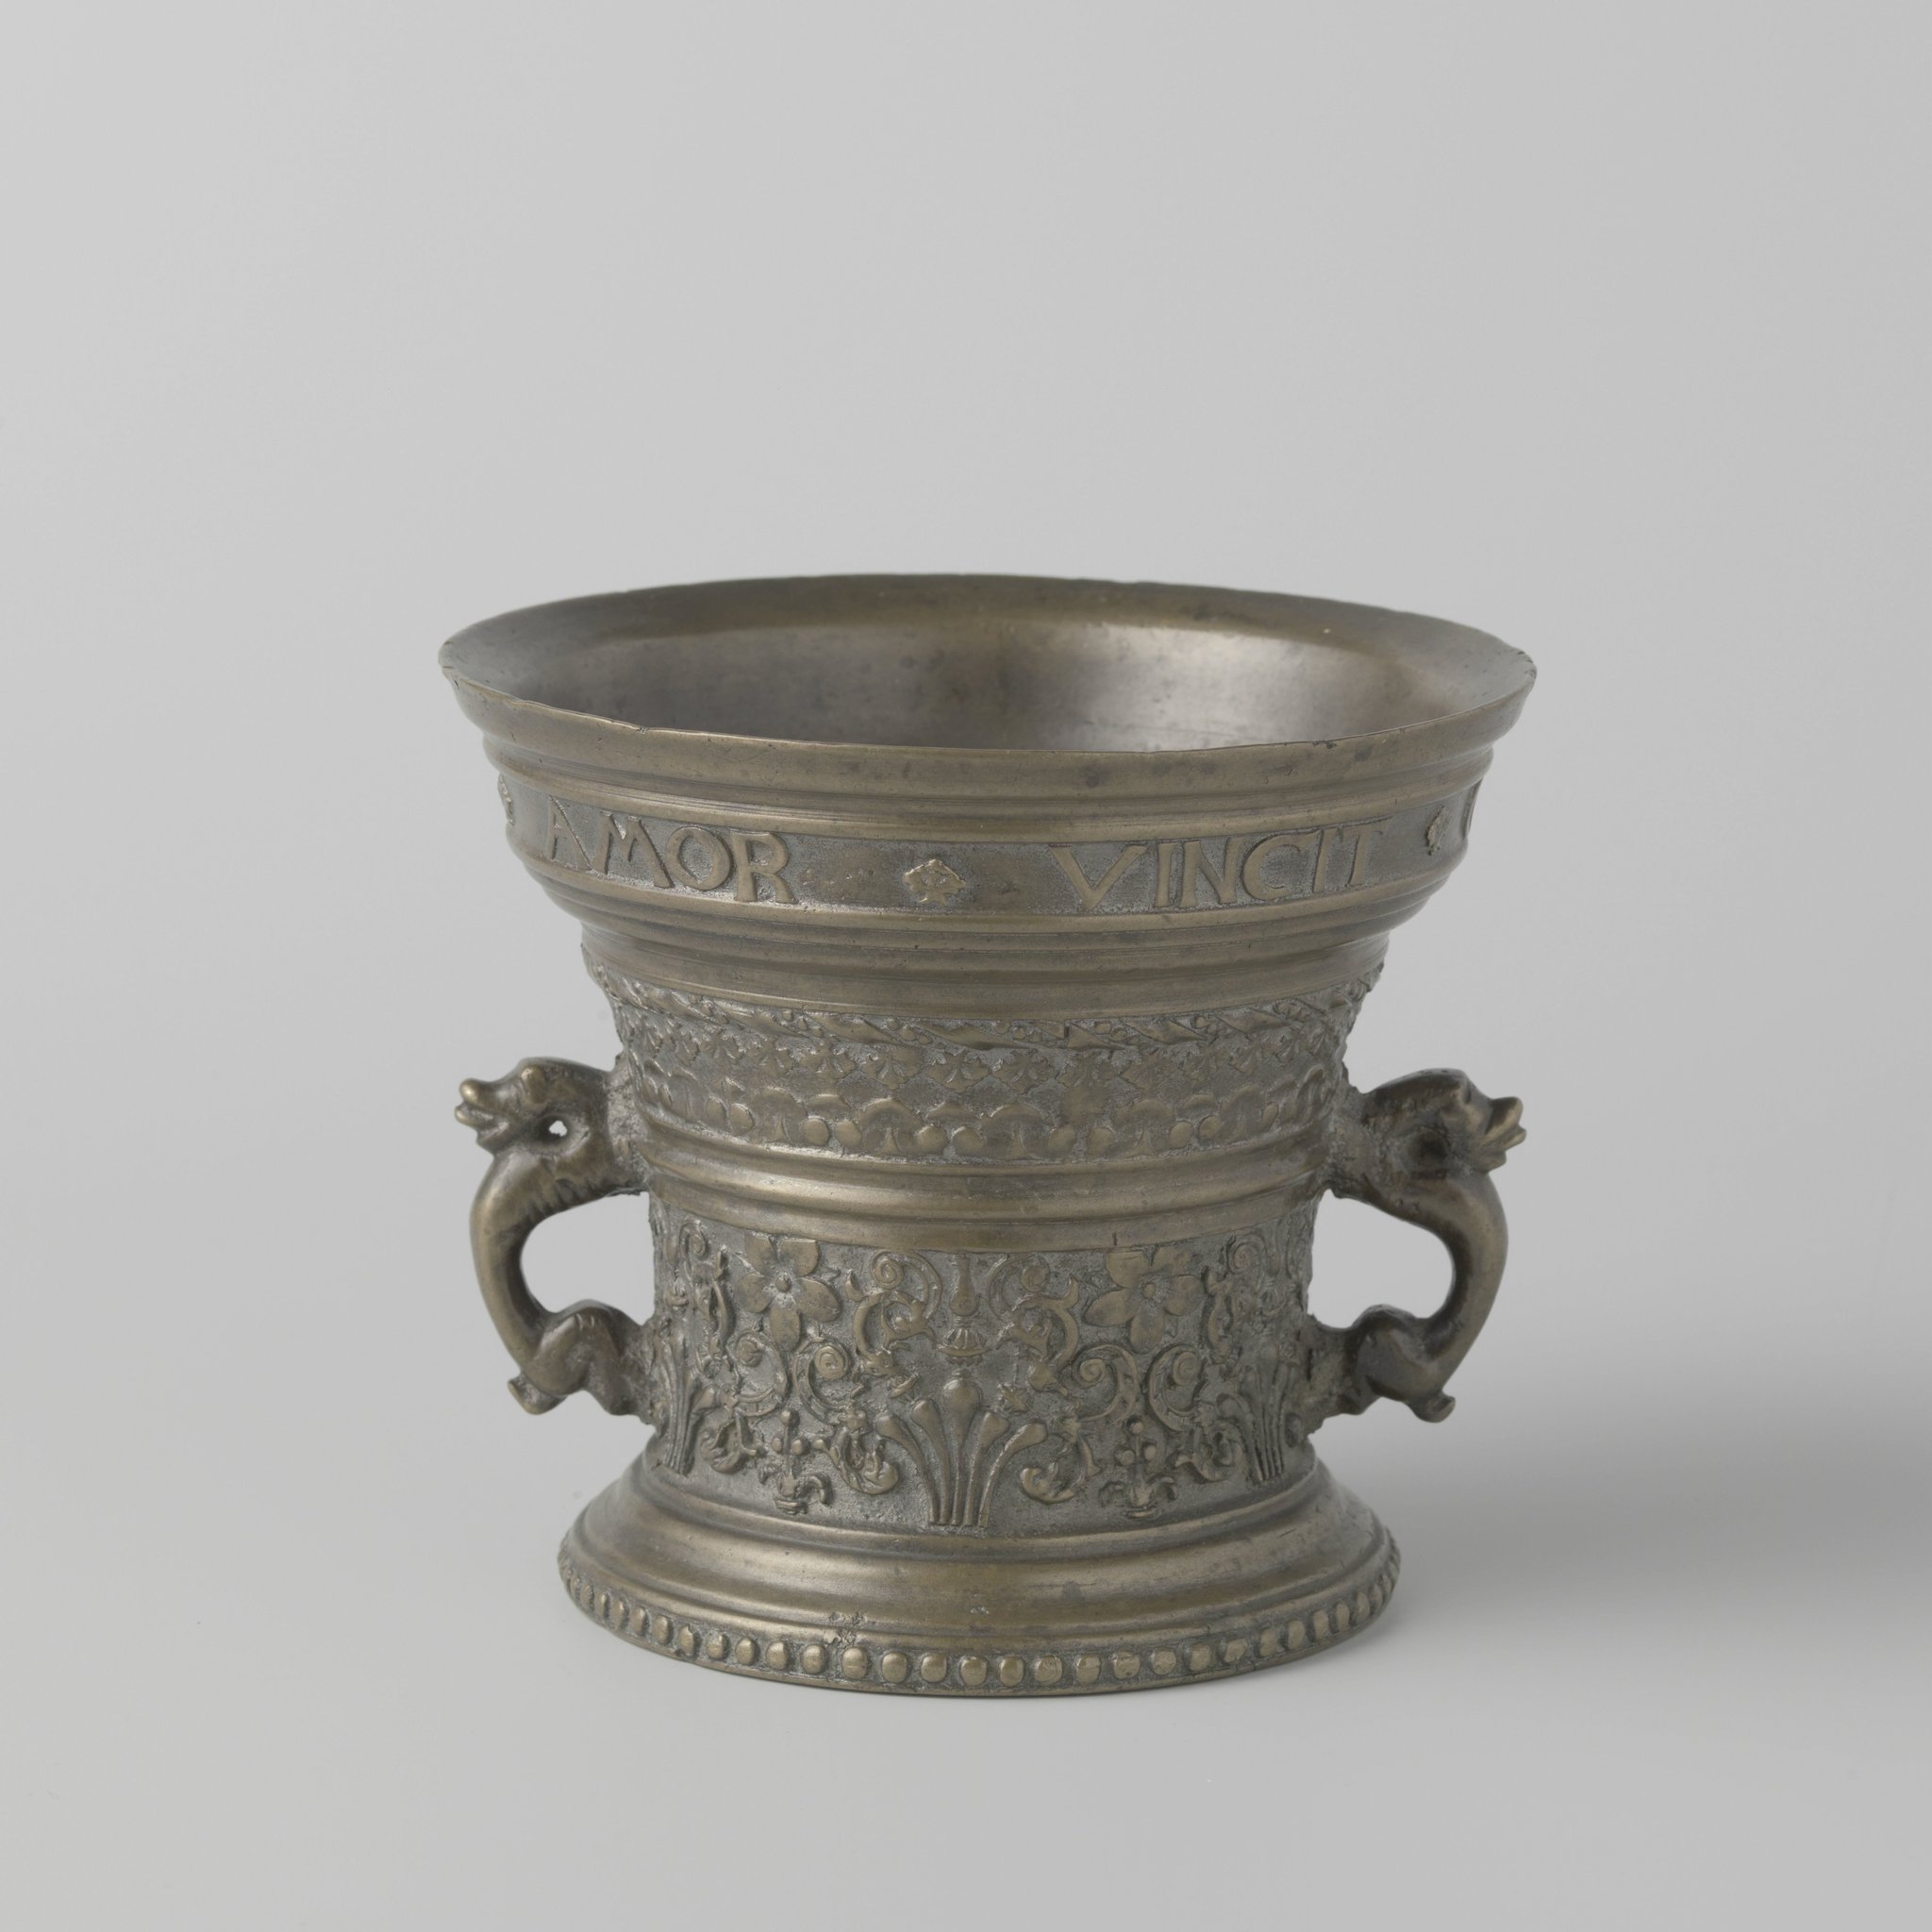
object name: mortar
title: Vijzel met opschrift: AMOR VINCIT OMNIA ANNO 1582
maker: willem wegewart (i)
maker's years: 1520-1600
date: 1582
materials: bronze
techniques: casting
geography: deventer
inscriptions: inscription: ‘AMOR VINCIT OMNIA ANNO 1582’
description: Mortar. Bronze. Deventer, 1582, Willem Wegewart the Elder (?). On loan from the Royal Antiquarian Society.